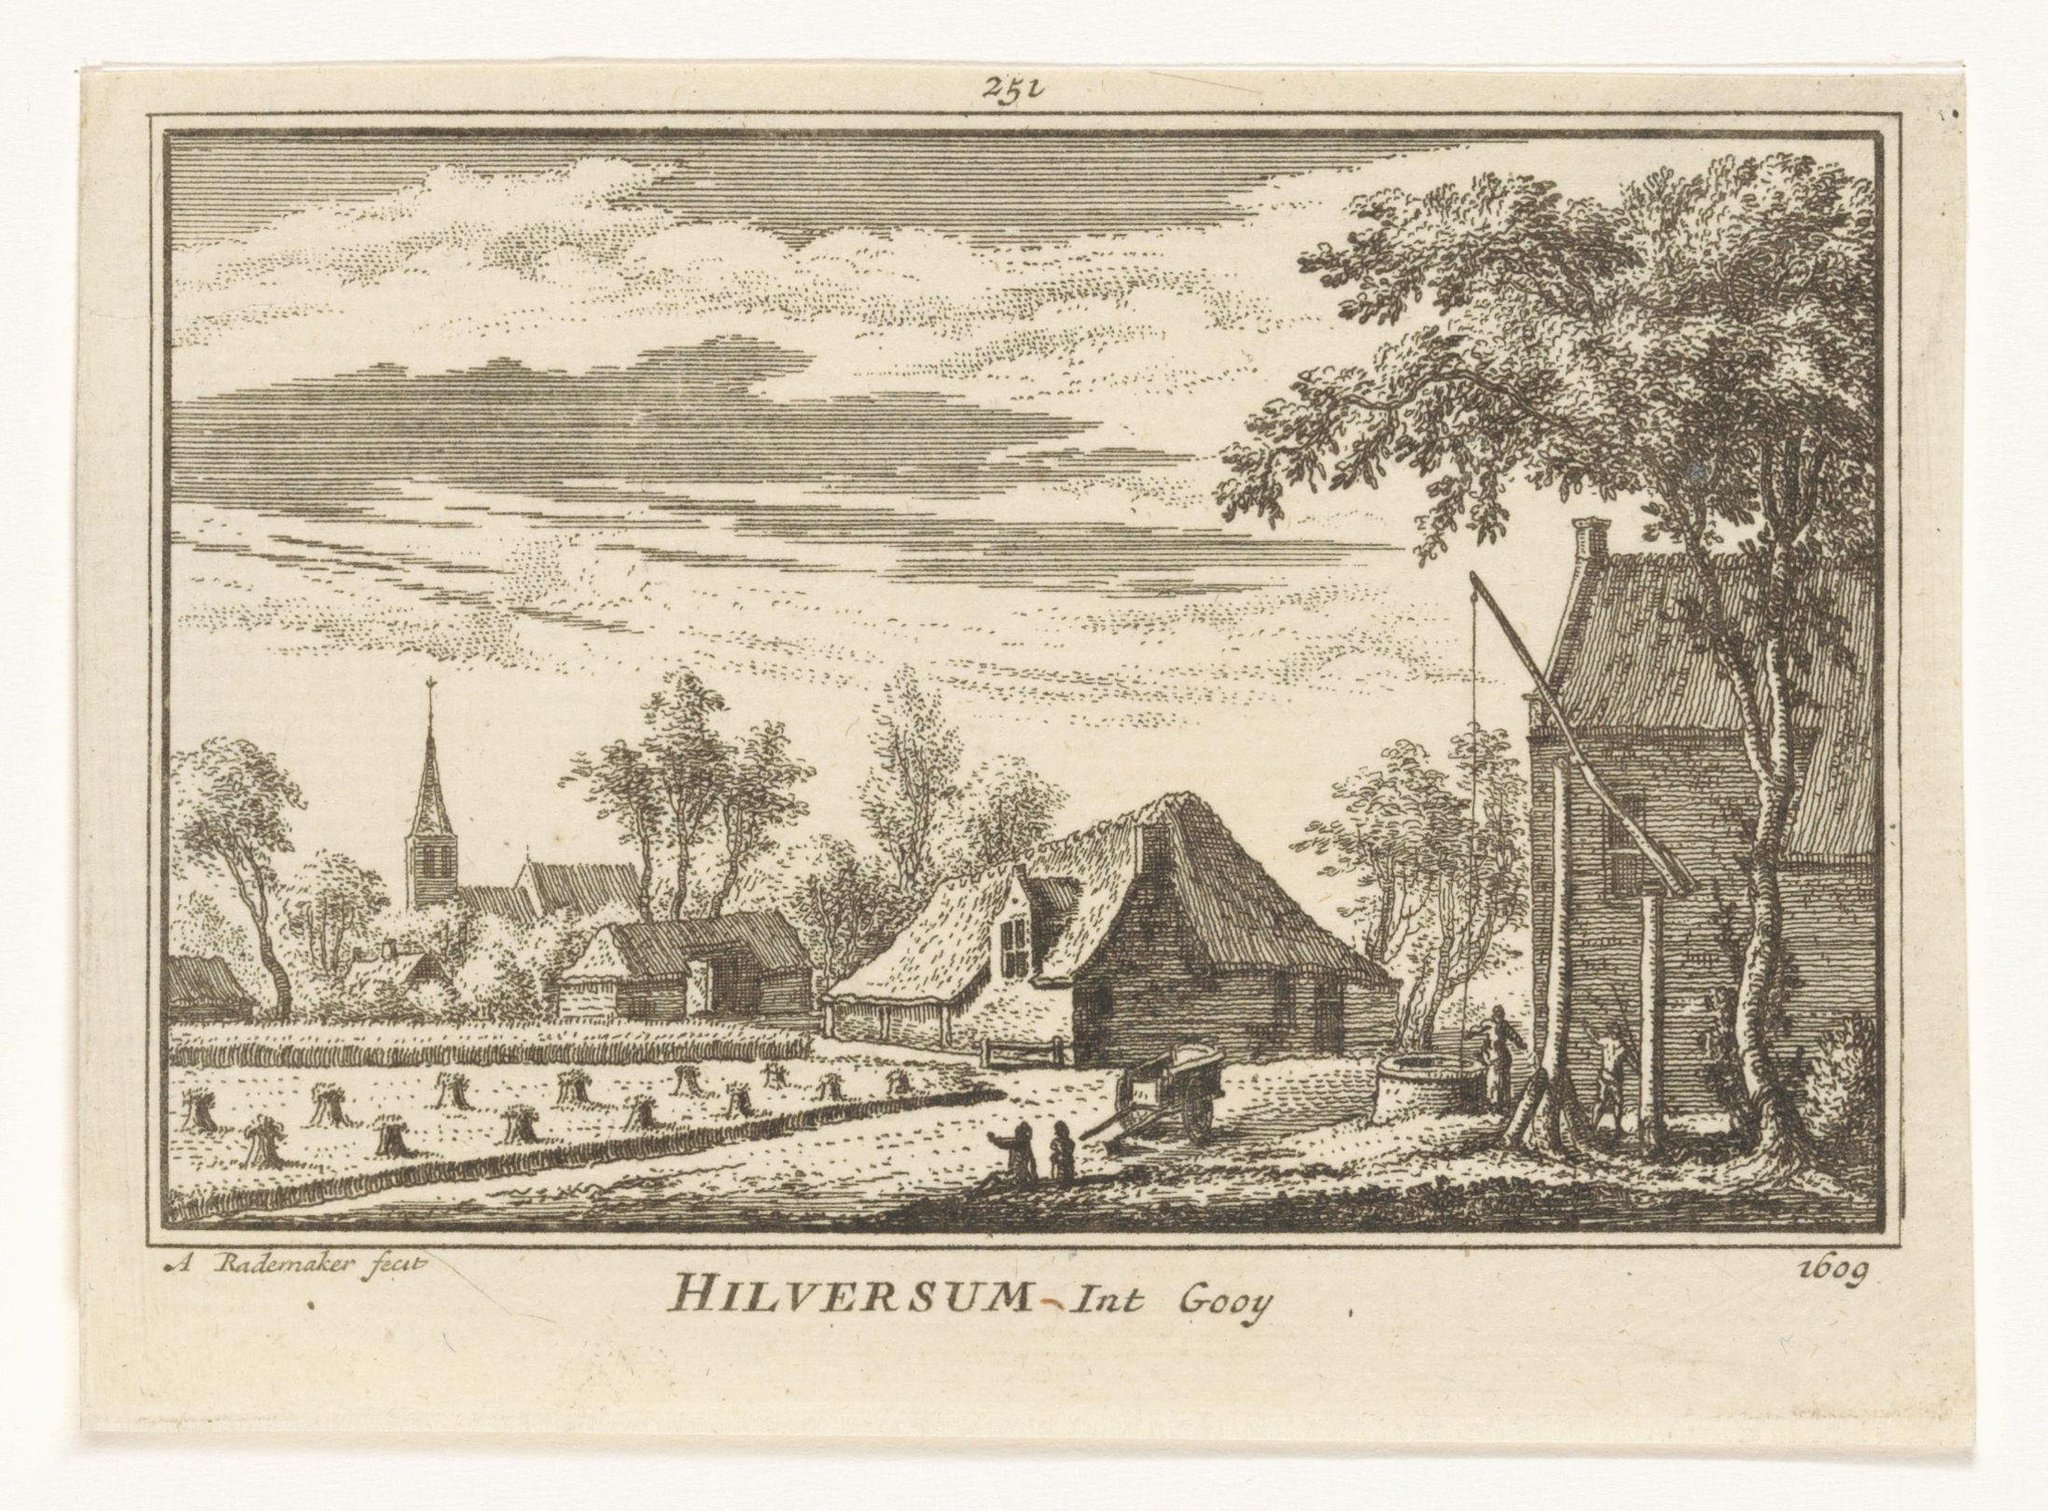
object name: print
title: Hilversum int Gooy 1609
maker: abraham rademaker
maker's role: draughtsman, print maker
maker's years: 1676-1735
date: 1725-1803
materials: paper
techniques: engraving, etching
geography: amsterdam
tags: prospect of village, silhouette of village, harvest, church (exterior), farm or solitary house in landscape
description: Prent ook gebruikt in: Rademaker, Abraham. Kabinet van Nederlandsche outheden en gezichten: vervat in 300 konstplaaten (…). 2 delen. Amsterdam: Willem Barents, 1725, dl. 2, ill. 251. Na 1725 is deze prent nog in verschillende heruitgaven verschenen, uitgegeven in 1727-1733, 1770-1771 en 1792-1803. Uit welke uitgave het huidige exemplaar precies komt is niet na te gaan.